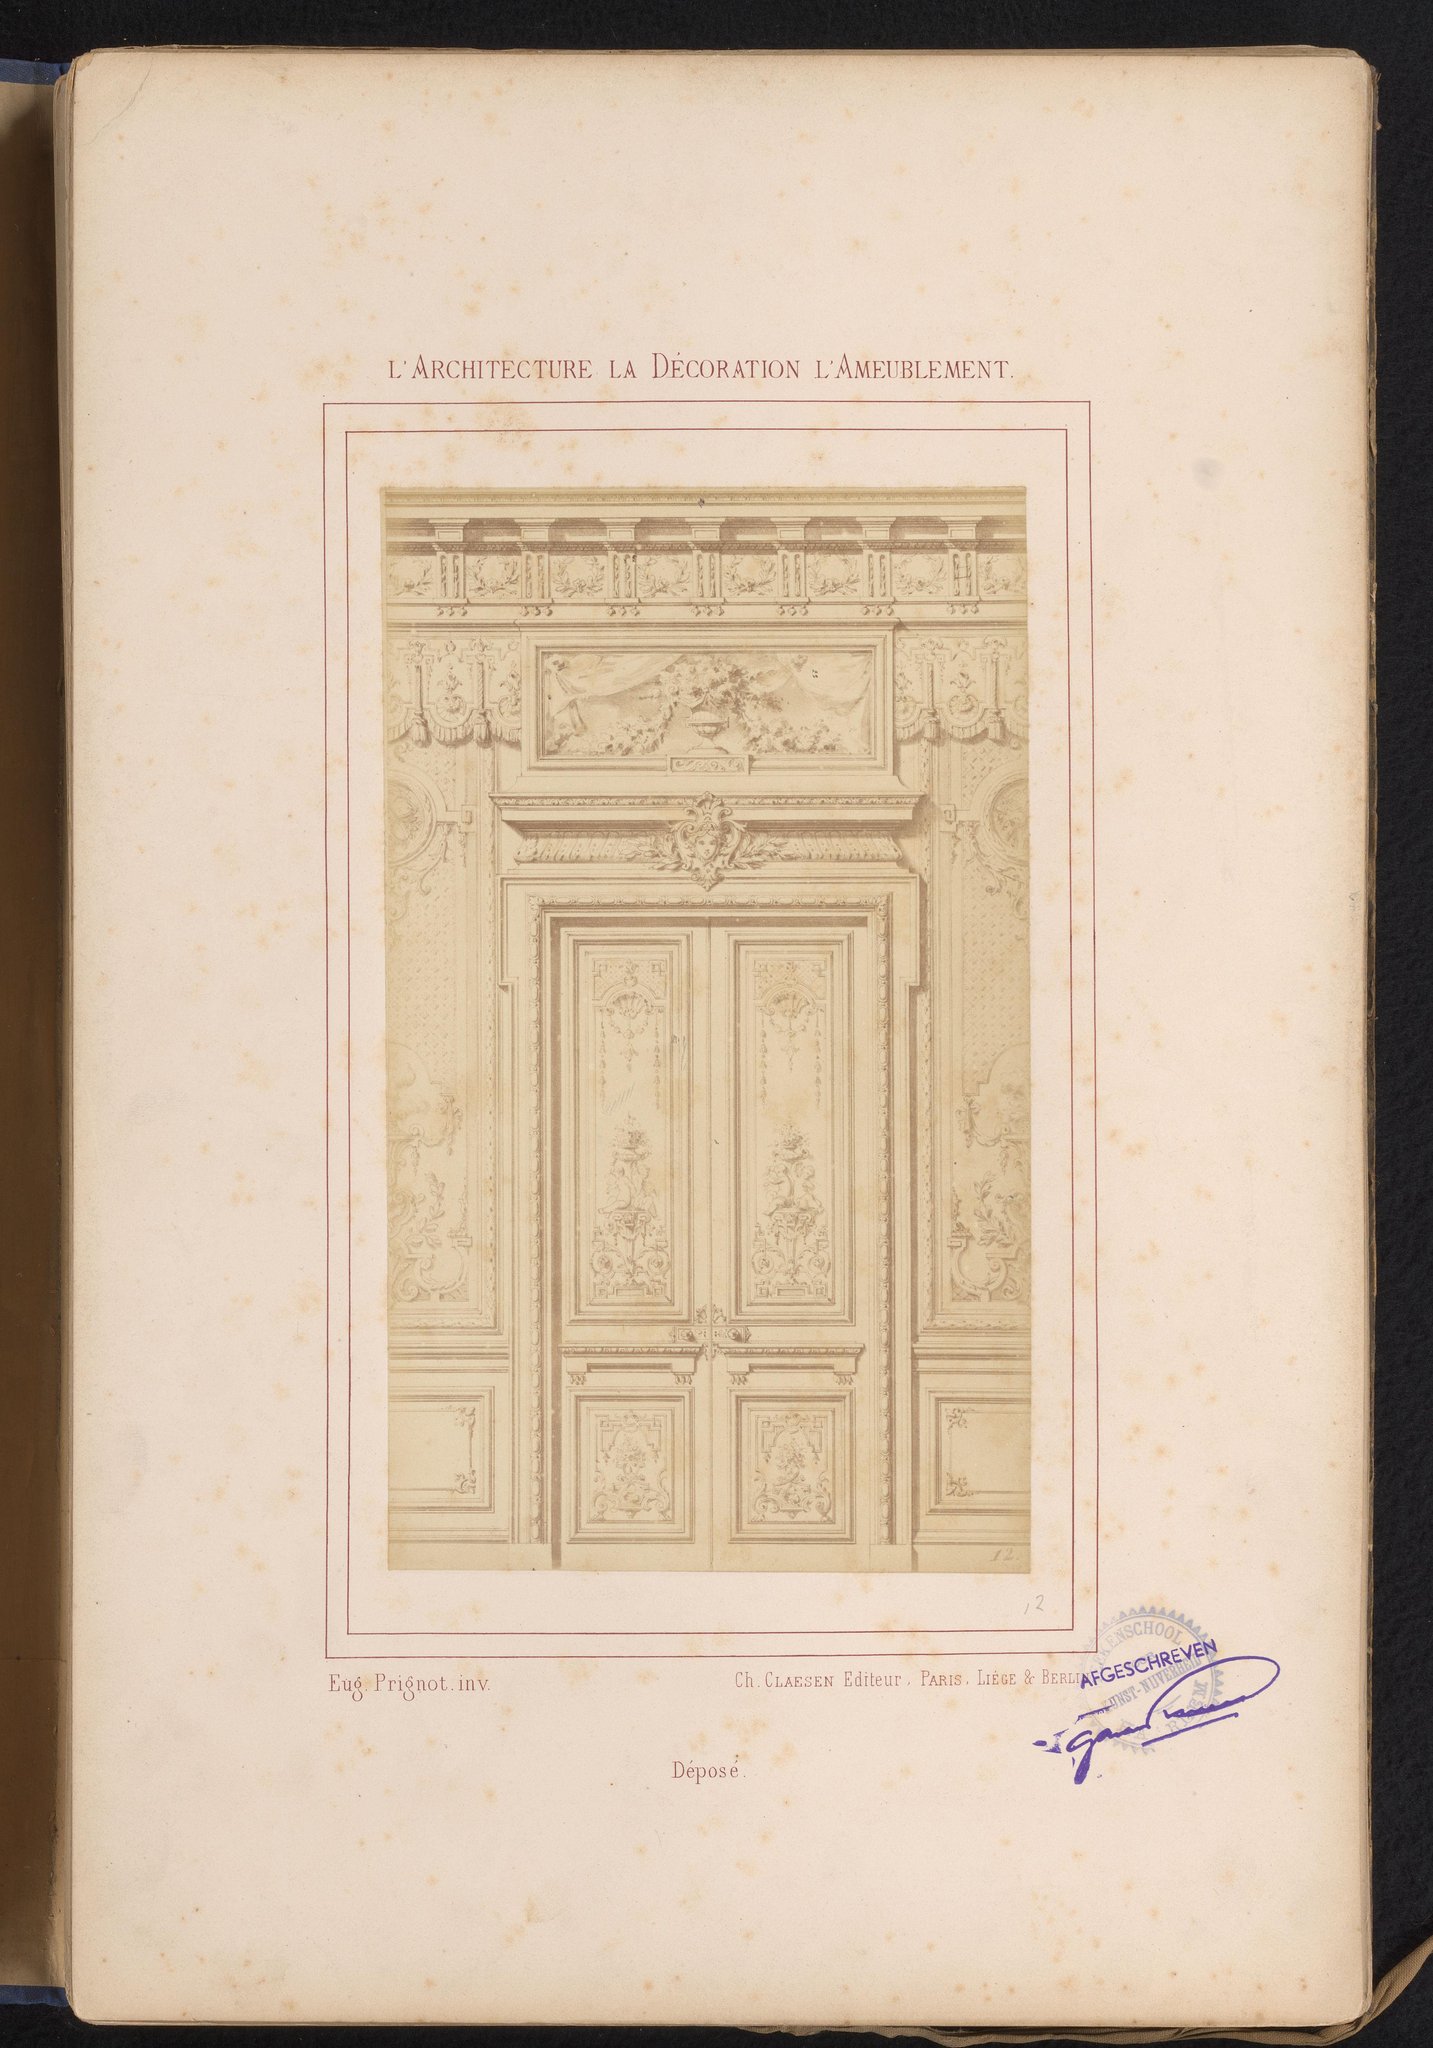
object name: photograph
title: Fotoreproductie van een ontwerp voor een deur naar Alexandre Eugène Prignot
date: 1873-1880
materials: cardboard, paper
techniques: albumen print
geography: liège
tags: door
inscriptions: number: ‘12’, stamp: ‘AFGESCHREVEN/ [...]’, inscription: ‘Eug. Prignot. inv.’, stamp: ‘TEEKENSCHOOL/ VOOR/ KUNSTNIJVERHEID/ HAARLEM’, inscription: ‘Déposé’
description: Deze foto maakt deel uit van een omslag met 61 foto's op 61 bladen.